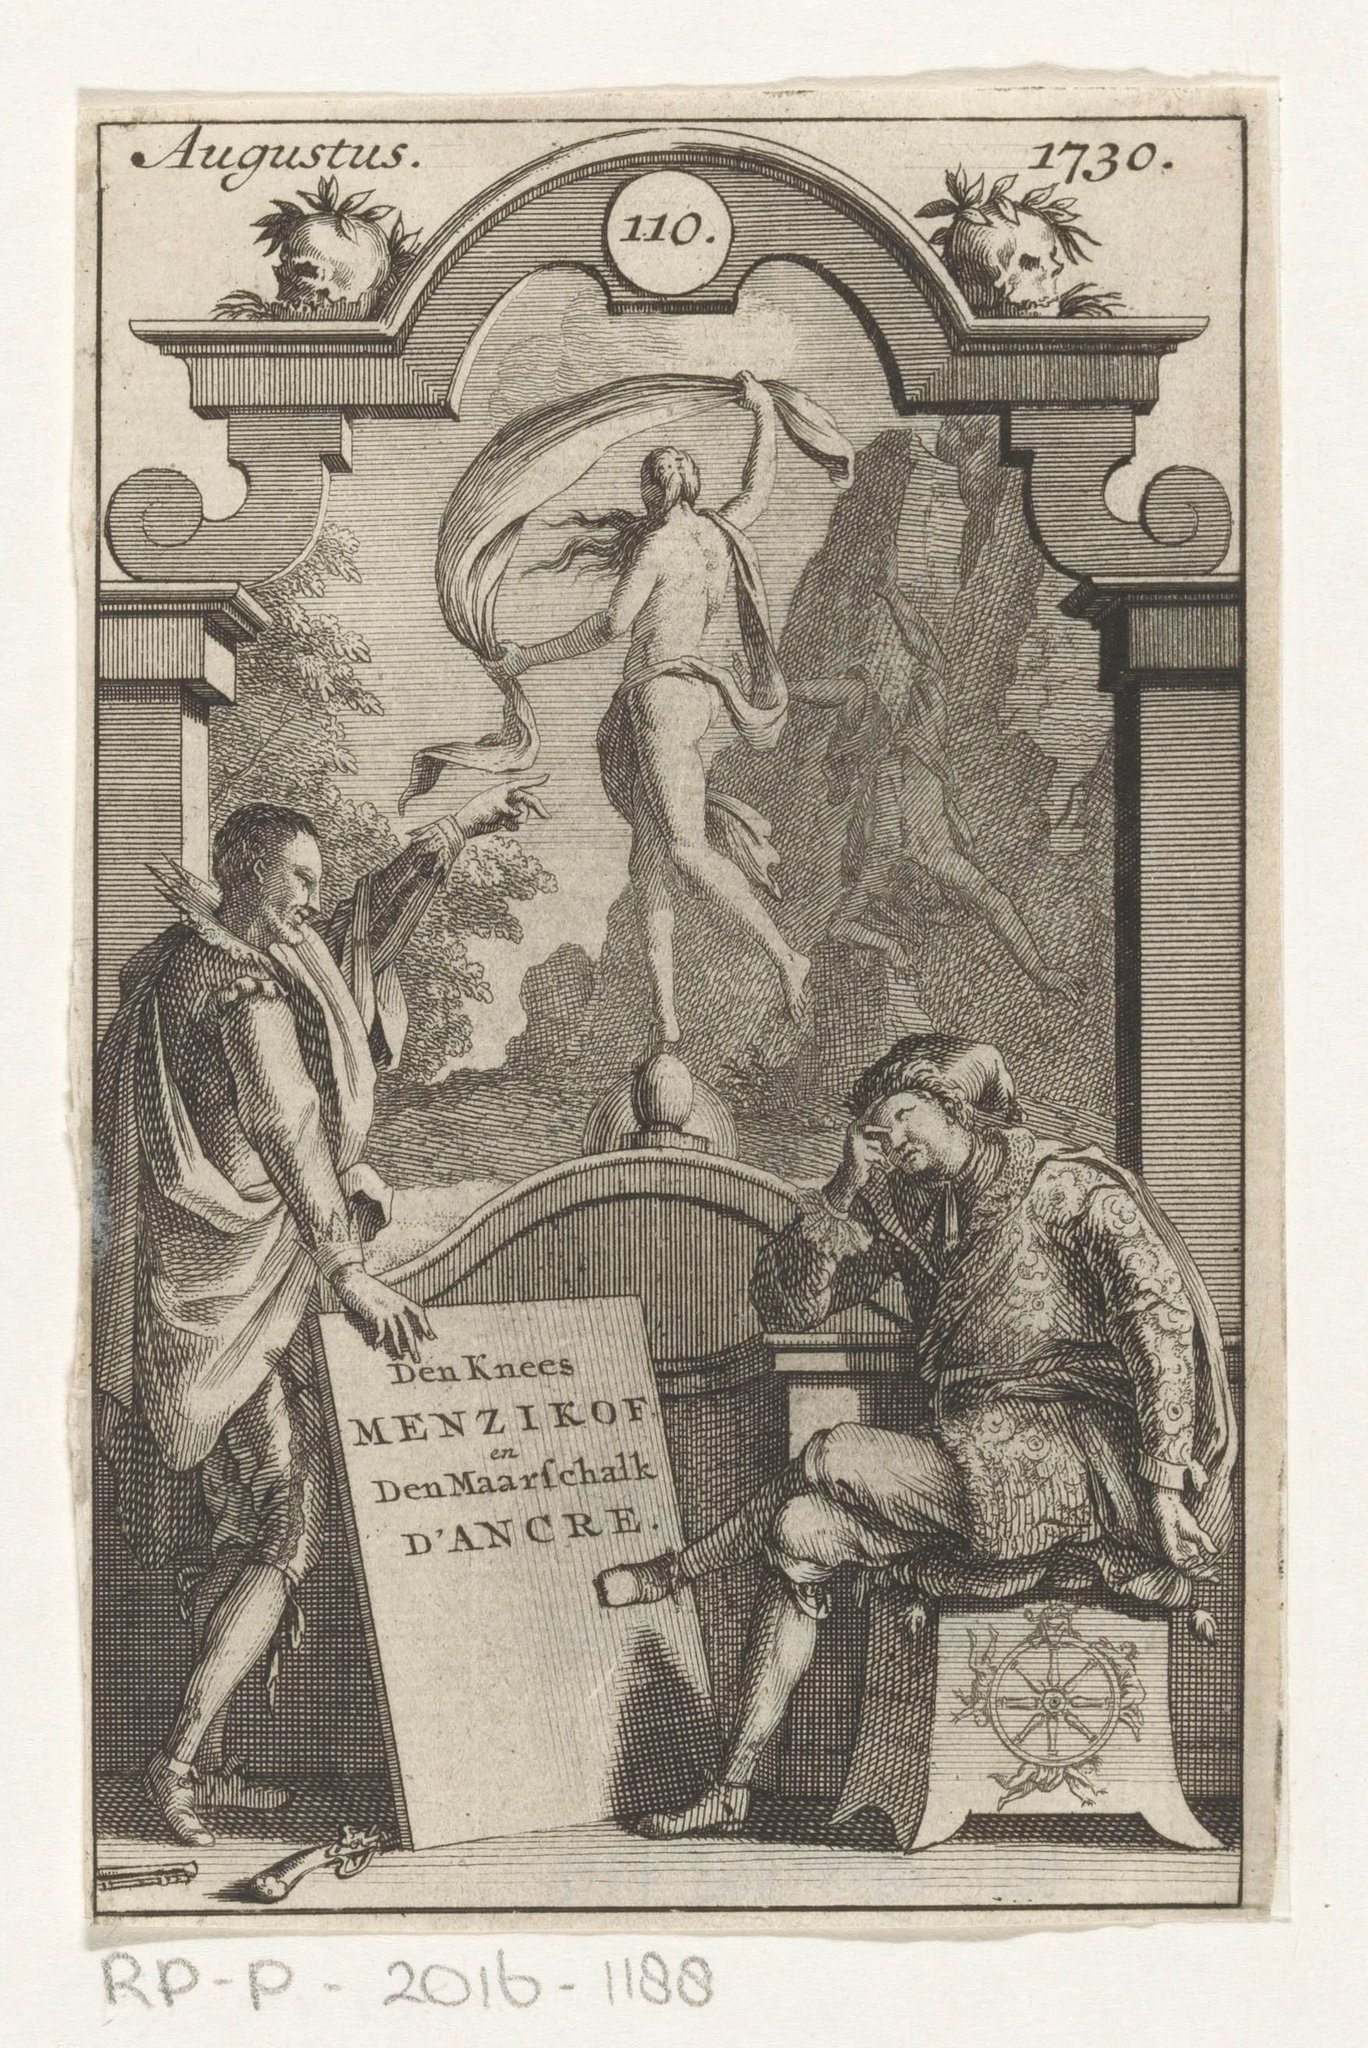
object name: print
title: Gesprek tussen Aleksandr Mensjikov en Concino Concini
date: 1708-1730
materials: paper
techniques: etching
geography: amsterdam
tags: paris, conversation, dialogue; conversation piece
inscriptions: collector's mark: Lugt 2228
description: Prent uit het tijdschrift: S.n. Maandelyksche berichten uit de andere waerelt; of de spreekende dooden. Amsterdam: Ratelband, weduwe Johannes, augustus 1730. Prent afkomstig uit een plakalbum met titelprenten, ornamenten etc. op blauw papier in 1983 uit elkaar gehaald. Volgens een notitie op verso zat de prent op p. 112 van dit album.